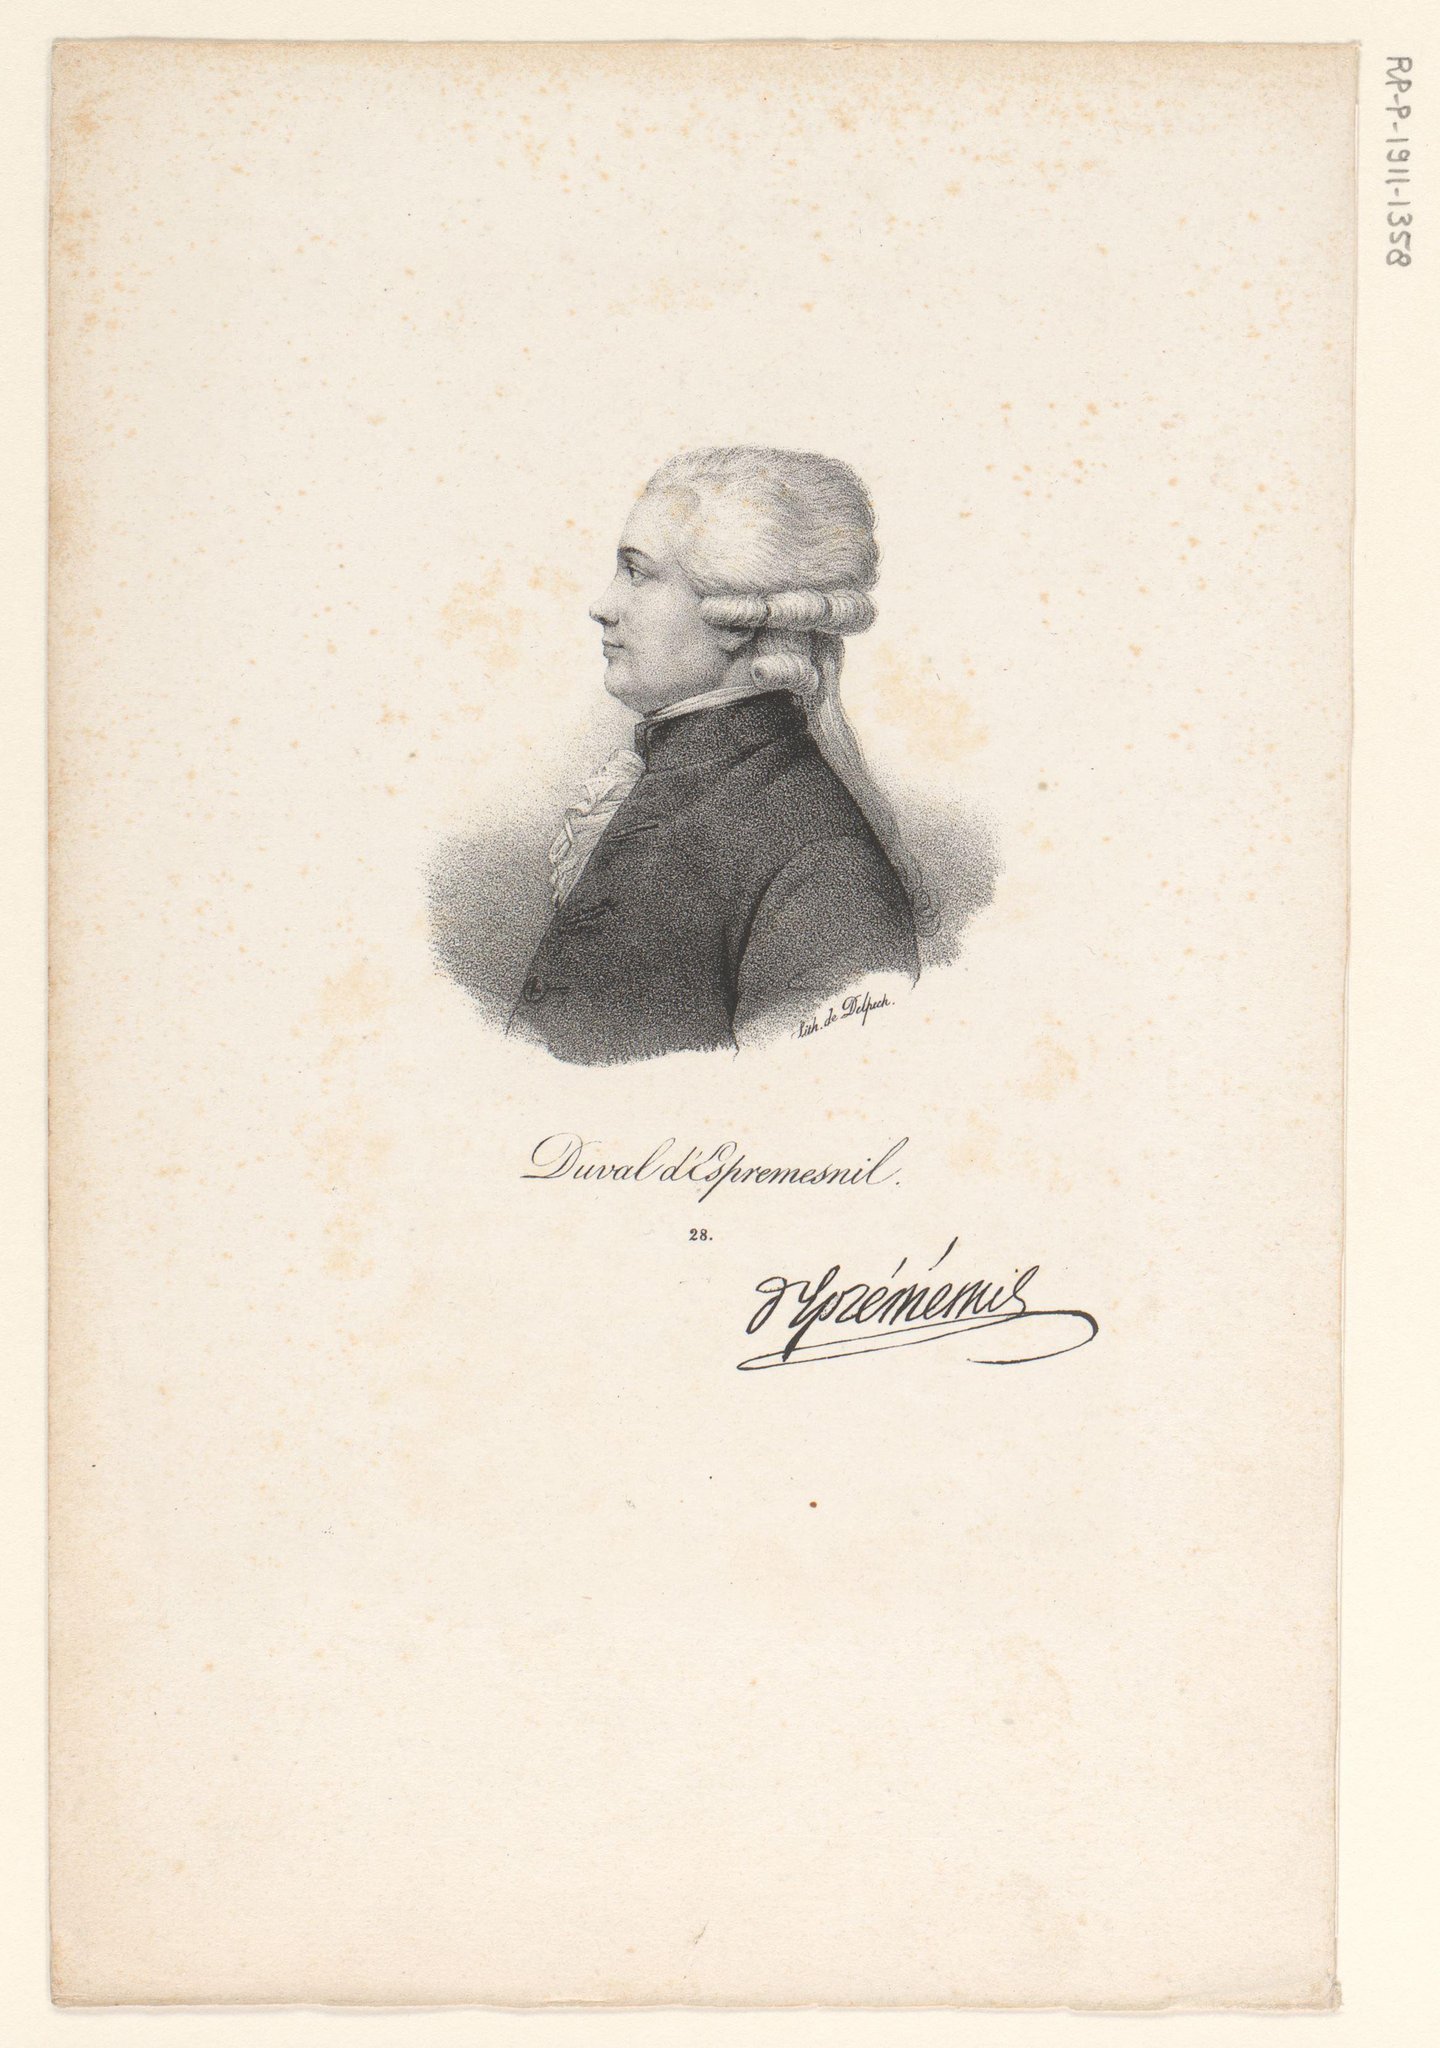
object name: print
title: Duval d'Epremesnil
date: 1818-1842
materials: paper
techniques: lithograph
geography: paris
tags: paris, politician, historical persons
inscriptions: collector's mark: Lugt 2228a